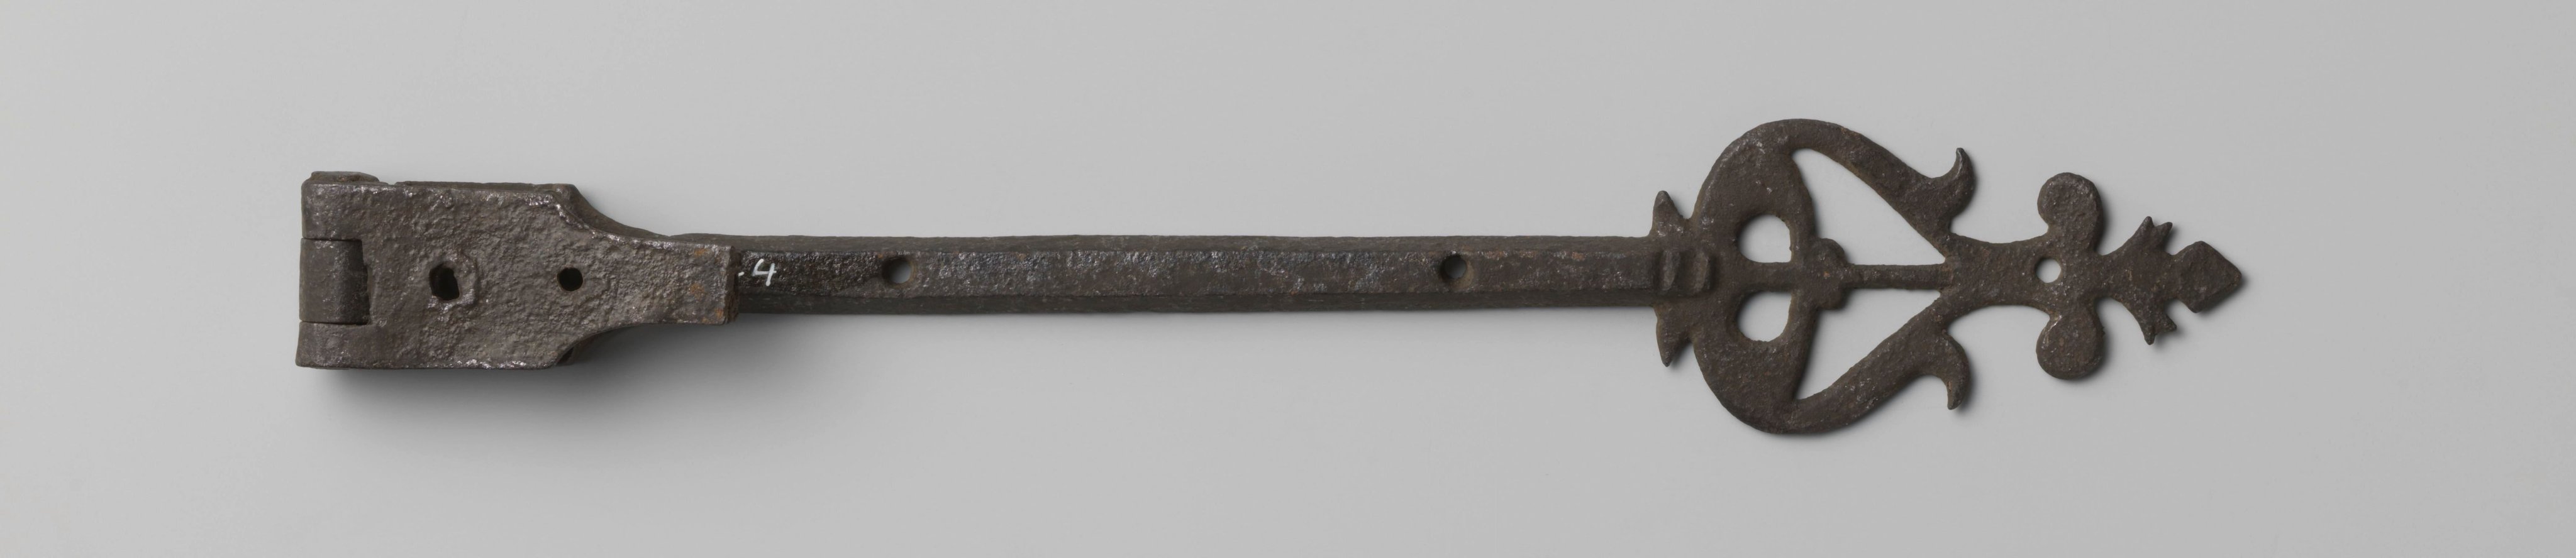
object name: hengsel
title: Hengsel van vertind ijzer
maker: Anonymous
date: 1600-1800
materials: tin, iron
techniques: tinning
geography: western europe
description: Hengsel van vertind ijzer. Vanaf het scharnier gezien, begint het beslag met een lange staaf, die uitmondt in een drietand, waarbij de middelste tand eindigt in een soort Franse lelie.